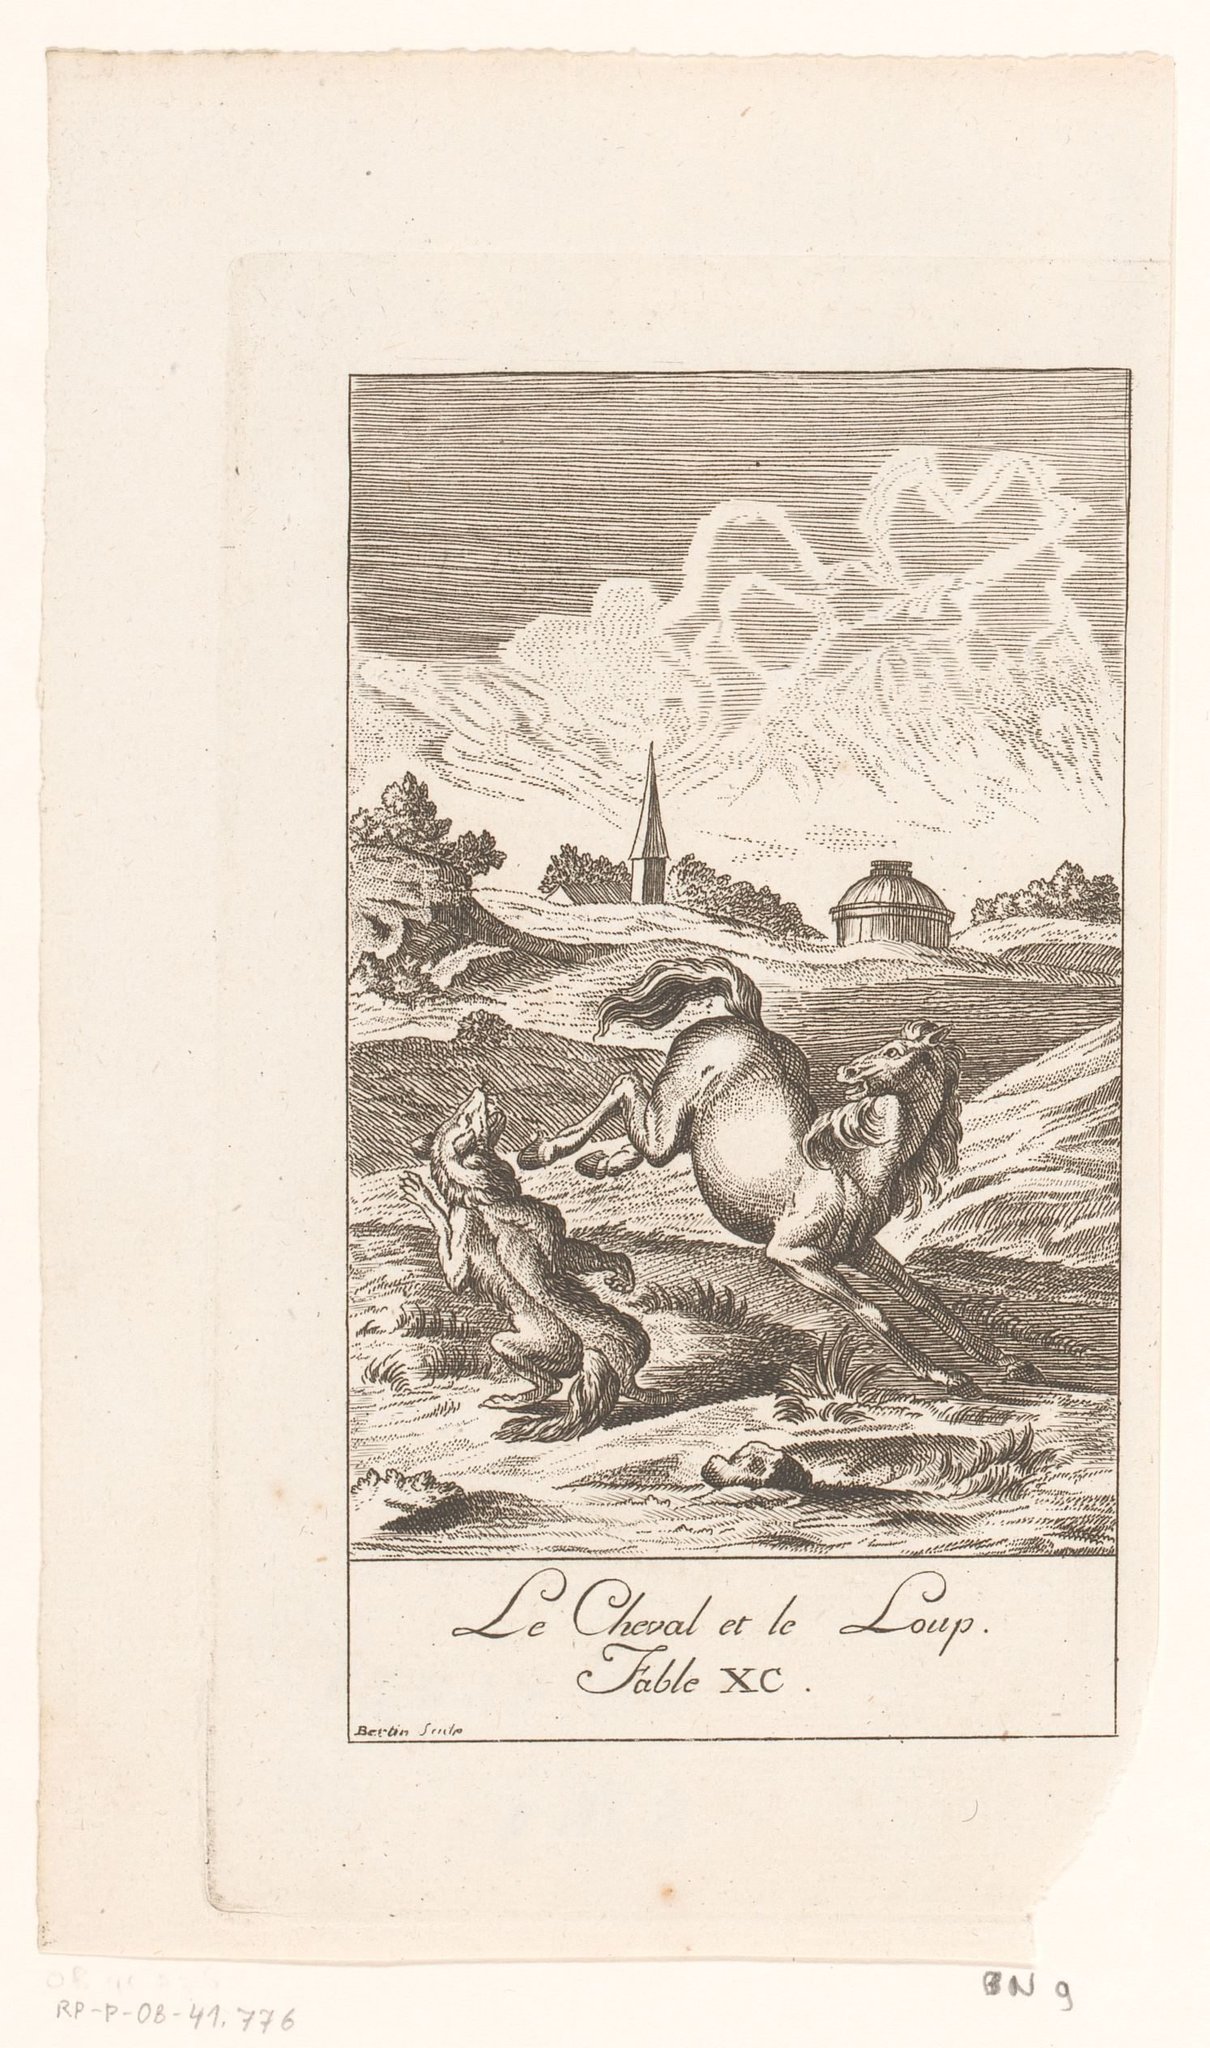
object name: book illustration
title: Le Cheval et le Loup.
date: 1776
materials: paper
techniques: etching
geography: france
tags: fables, horse, beasts of prey, predatory animals: wolf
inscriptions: collector's mark: Lugt 2228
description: Prent uit: Fontaine, Jean de la. Fables Choisies: Bouillon, Aux depens de la Société typographique. S.l.: s.d, 1776, dl. 2.